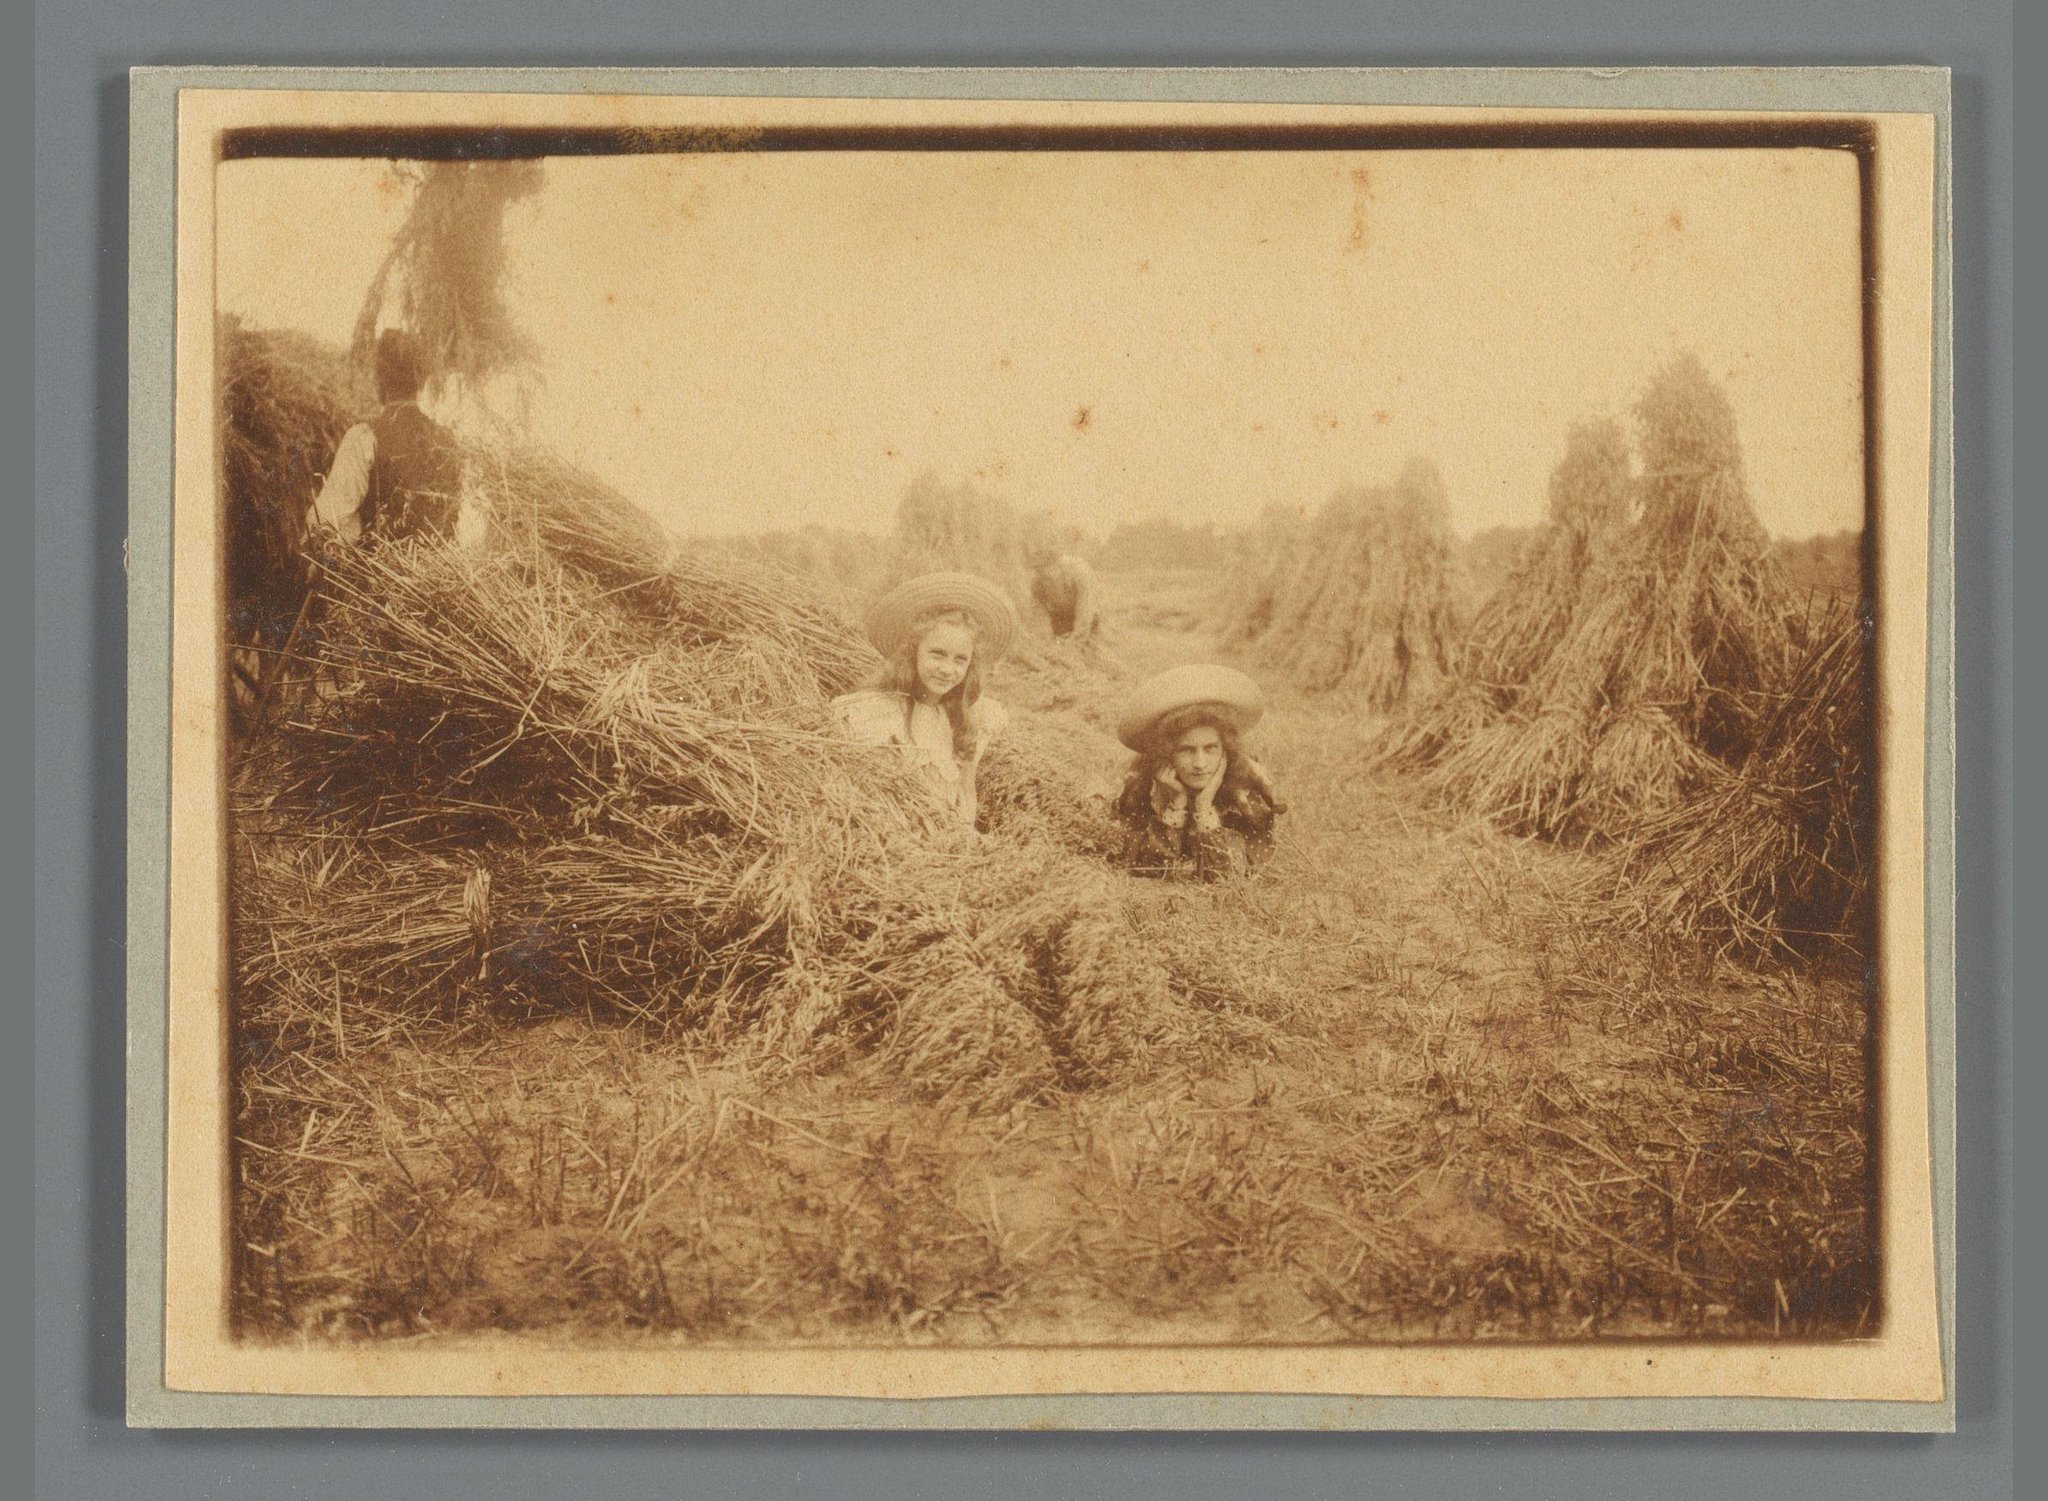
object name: photograph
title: Johanna (Hans) de Jong en Johanna (Nan) Vreede bij stapels hooi in een weiland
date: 1905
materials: cardboard, paper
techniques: collodion silver print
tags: leiden, johanna petronella lambertina stokhuyzen-de jong (hans), johanna elisabeth borgerhoff mulder-vreede (nan), child, historical persons, hay-stack